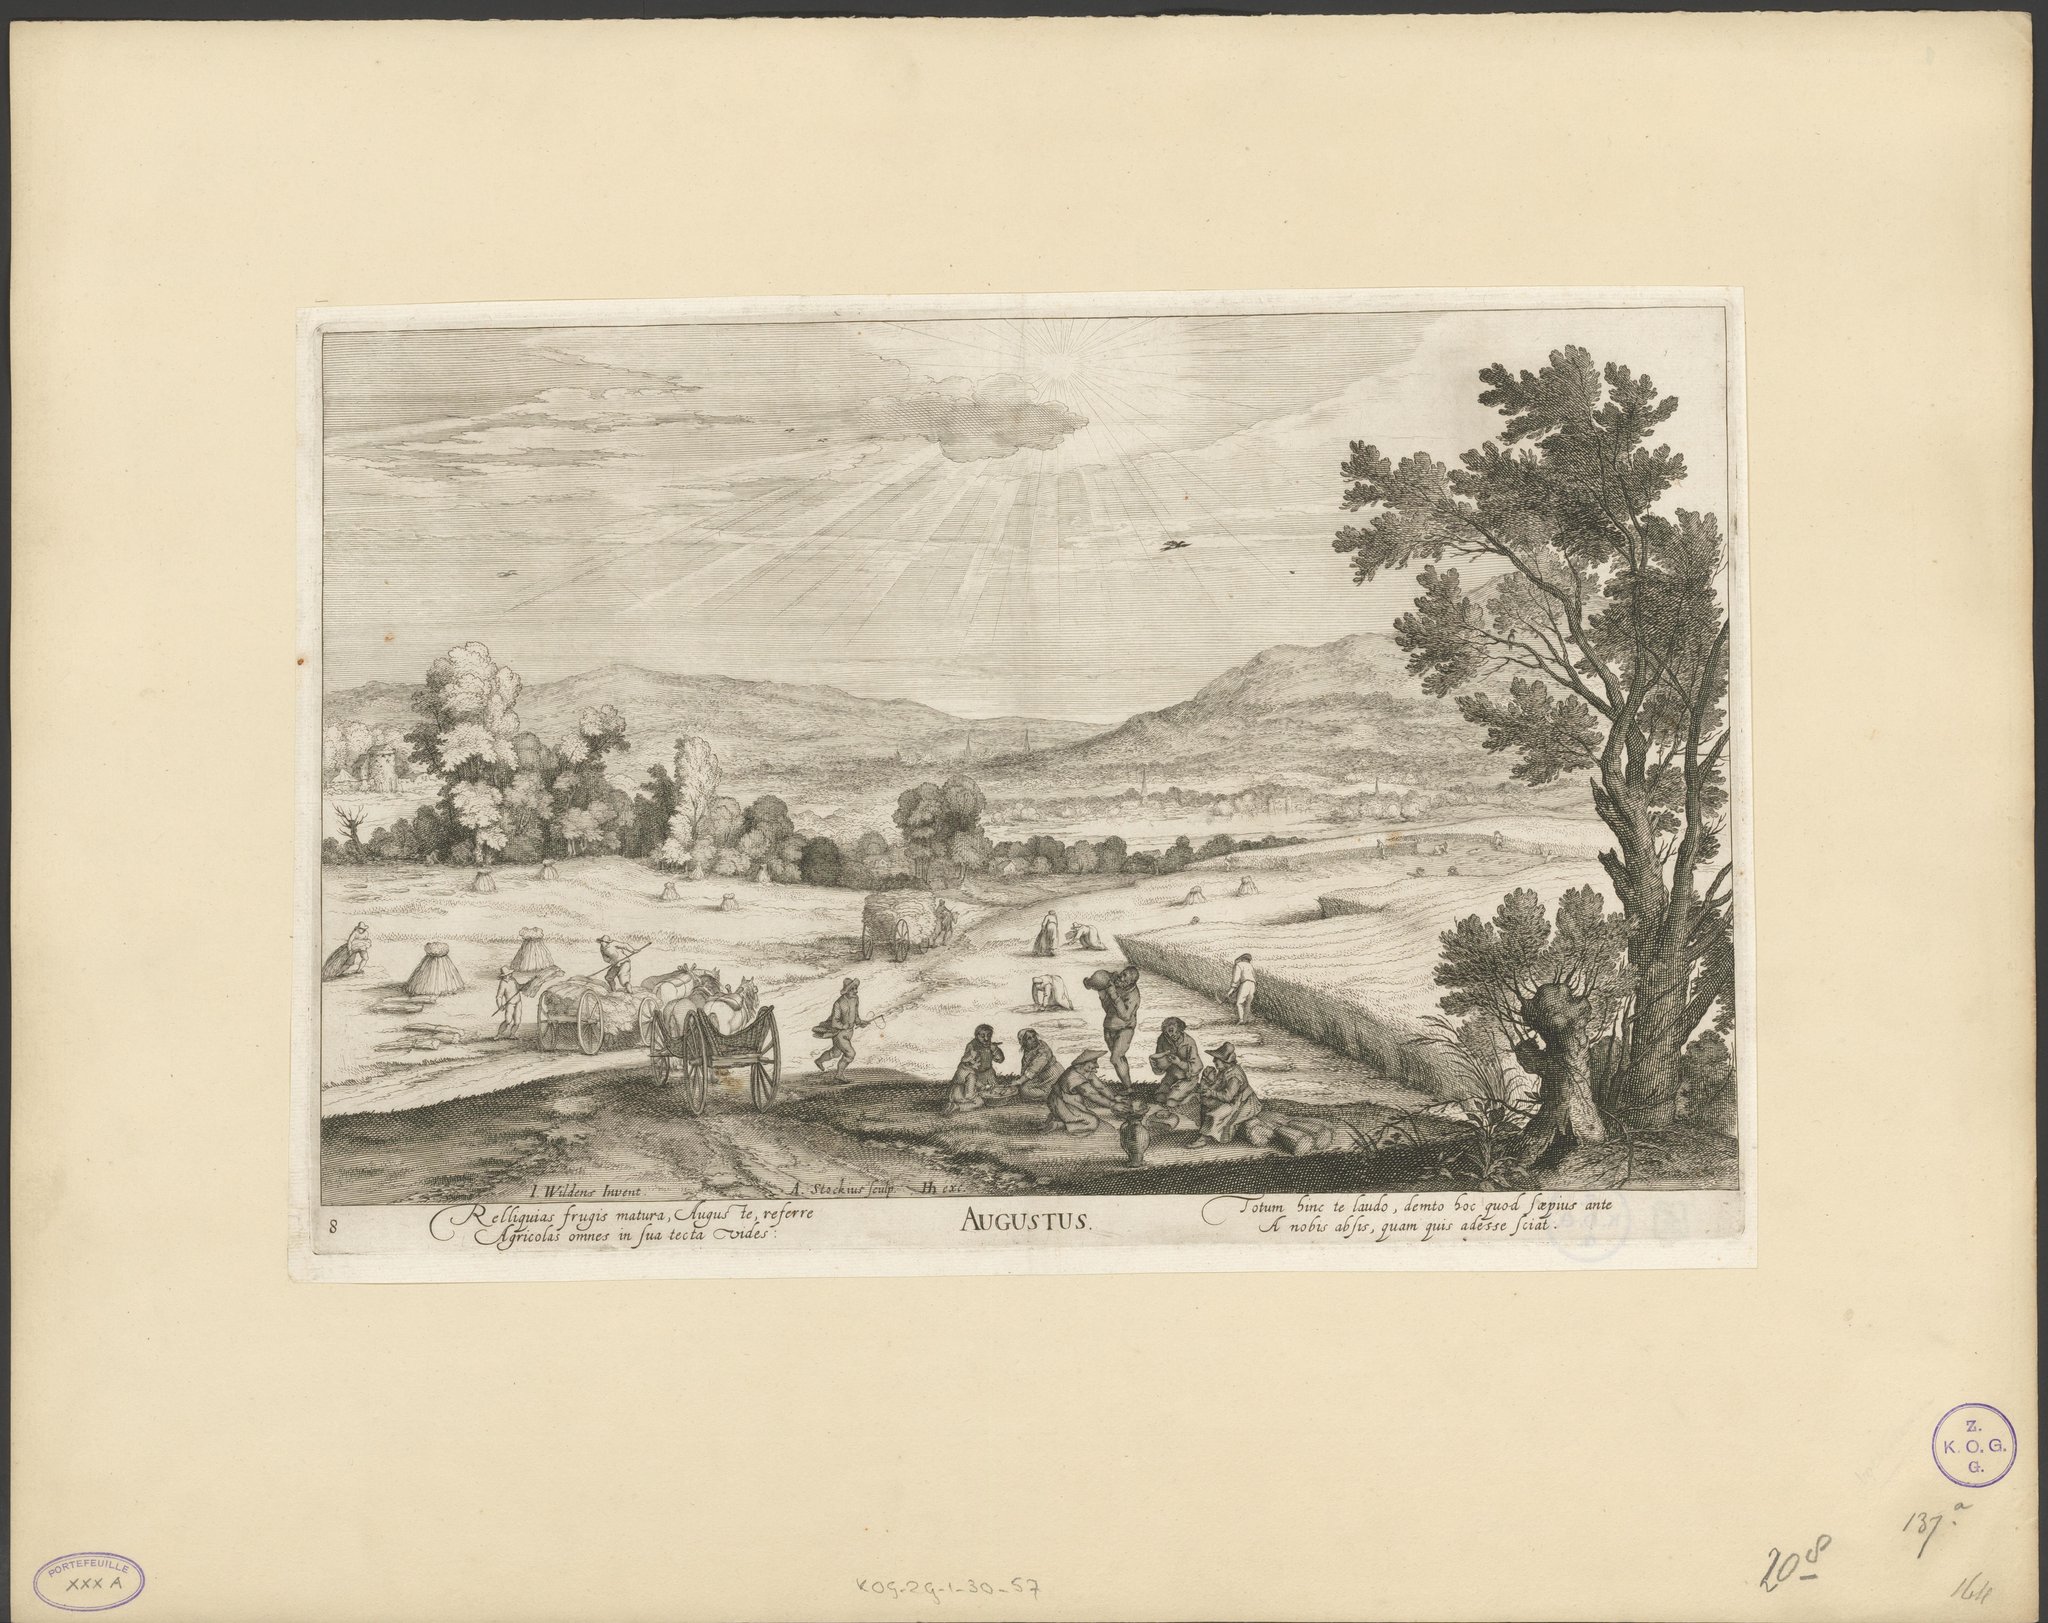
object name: print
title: Augustus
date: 1614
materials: paper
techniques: engraving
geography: the hague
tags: landscape symbolizing august (+ with scenes showing human occupations ~ seasons and months), august and its 'labours'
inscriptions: collector's mark: Lugt 1641, stamp, stamp: 963, collector's mark: Lugt 1641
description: Landschap met op de voorgrond enkele mensen, die rusten tijdens de oogst. Links worden schoven bijeen gebonden. Rechts oogsten mensen het graan. Verbeelding van de maand Augustus. Prent uit een serie van de twaalf maanden. Onderwerpsrubrieken binnen de Atlas Zeden en Gewoonten: Zeden en Gewoonten in engeren zin. Zinnebeeldige voorstellingen uit het volkleven op serieprenten. Maanden en diversen (allegorieën).